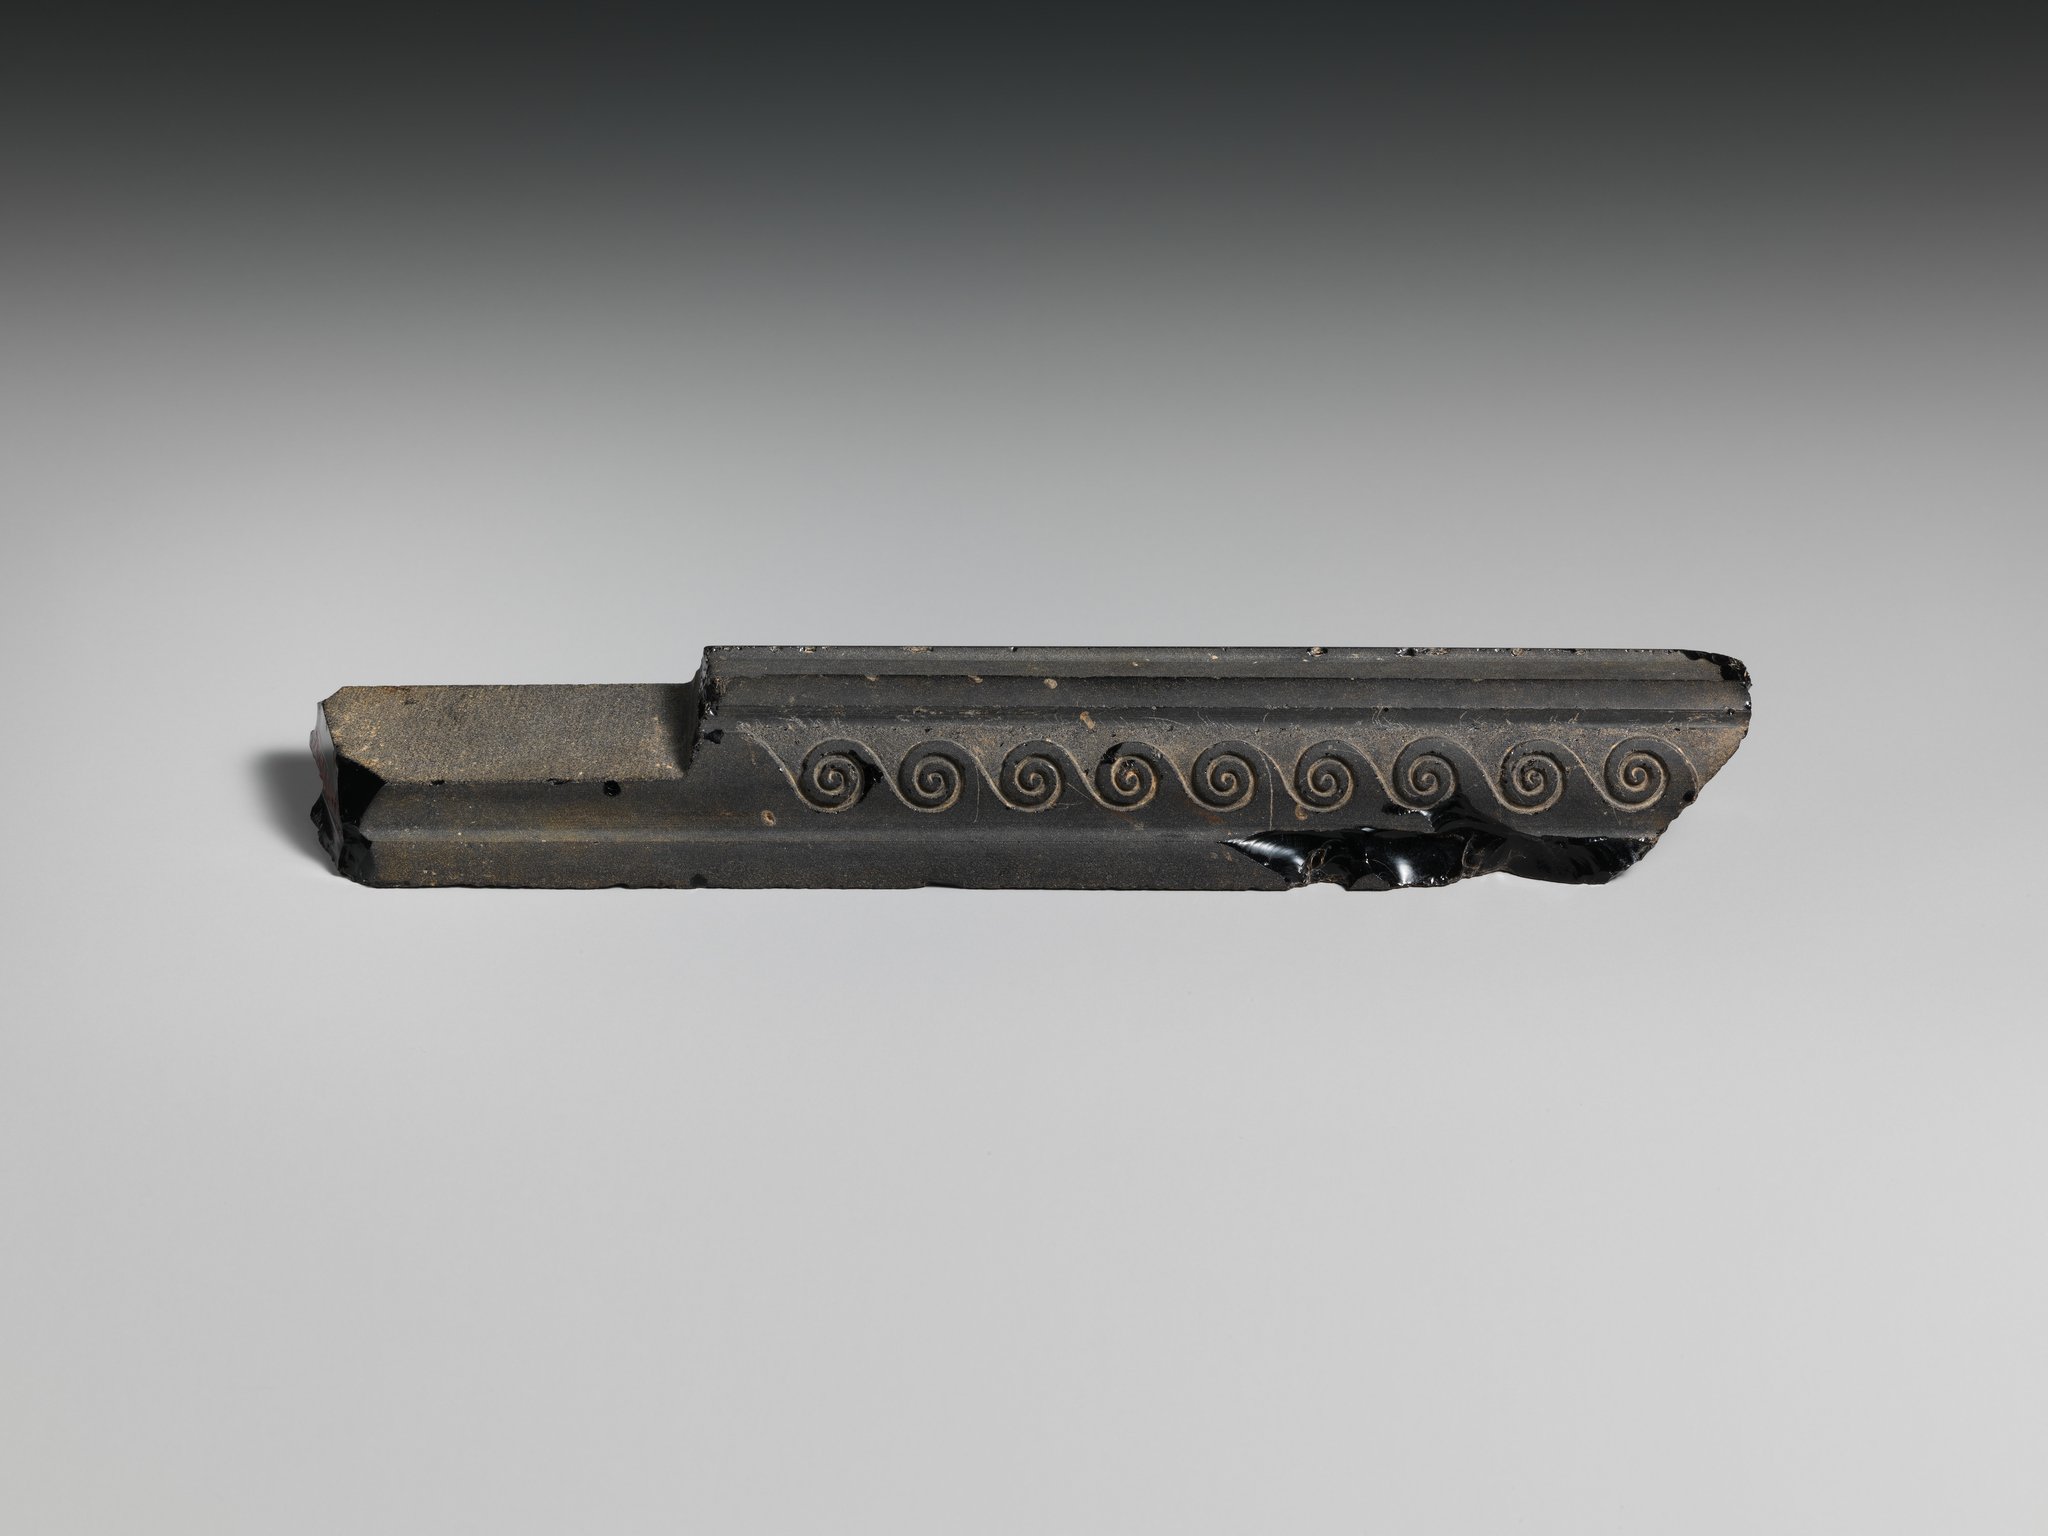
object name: furniture attachment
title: Obsidian furniture attachment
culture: roman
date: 25 BCE-10 CE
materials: obsidian